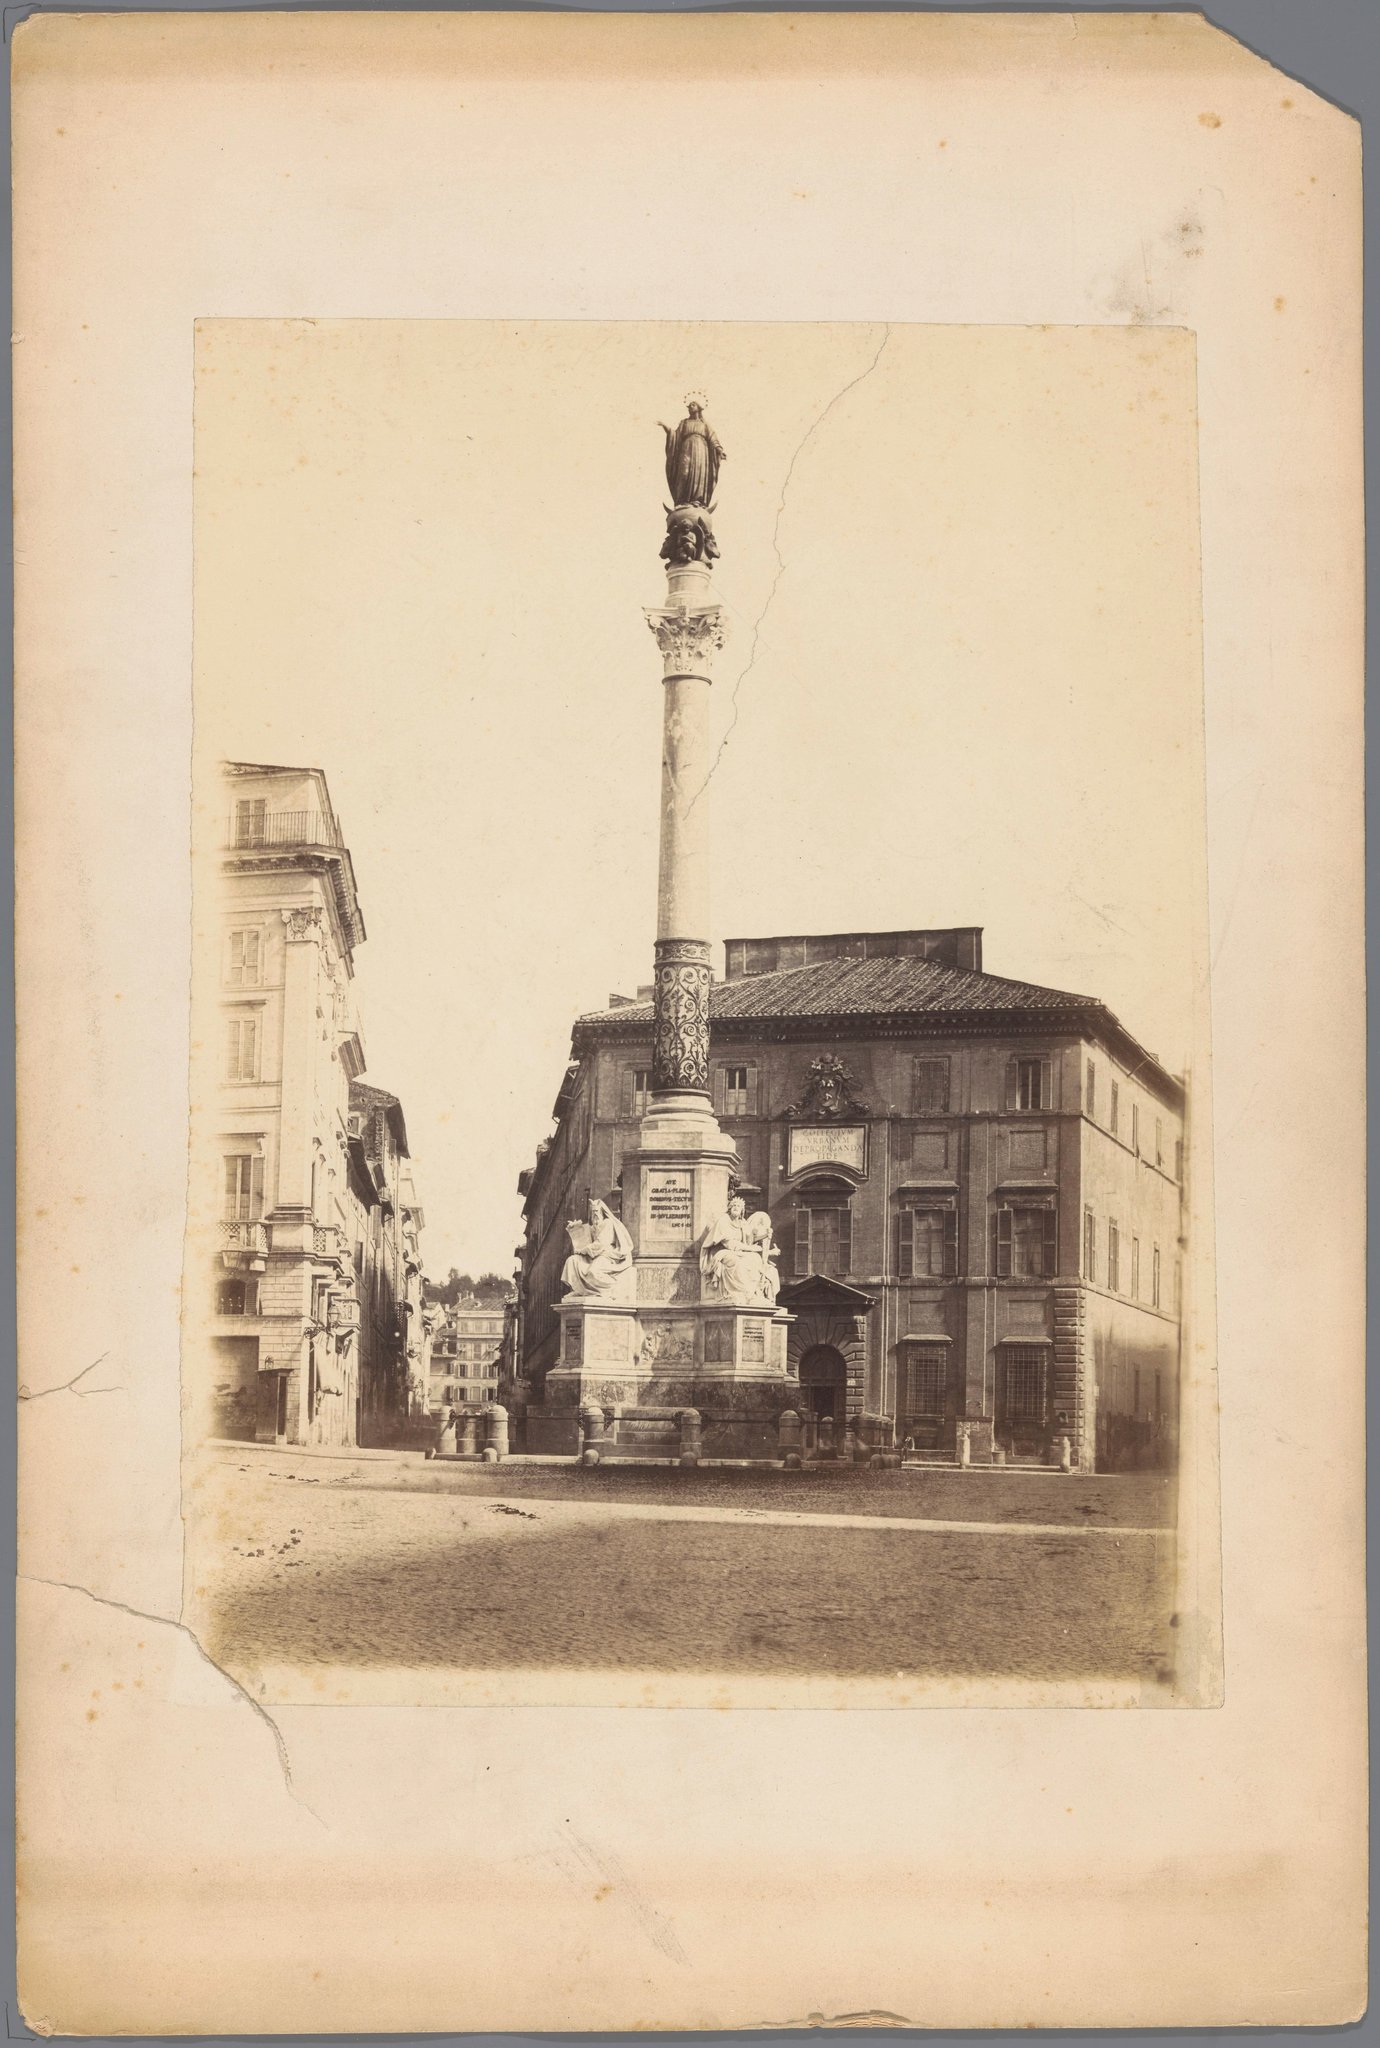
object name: photograph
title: Zuil van de Onbevlekte Ontvangenis te Rome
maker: gustave eugène chauffourier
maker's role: fotograaf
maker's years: 1845-1919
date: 1875-1900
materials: photographic support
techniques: albumen print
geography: italy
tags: square, place, circus, etc., column, pillar ~ architecture, sculpture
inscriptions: collector's mark: Lugt 3937